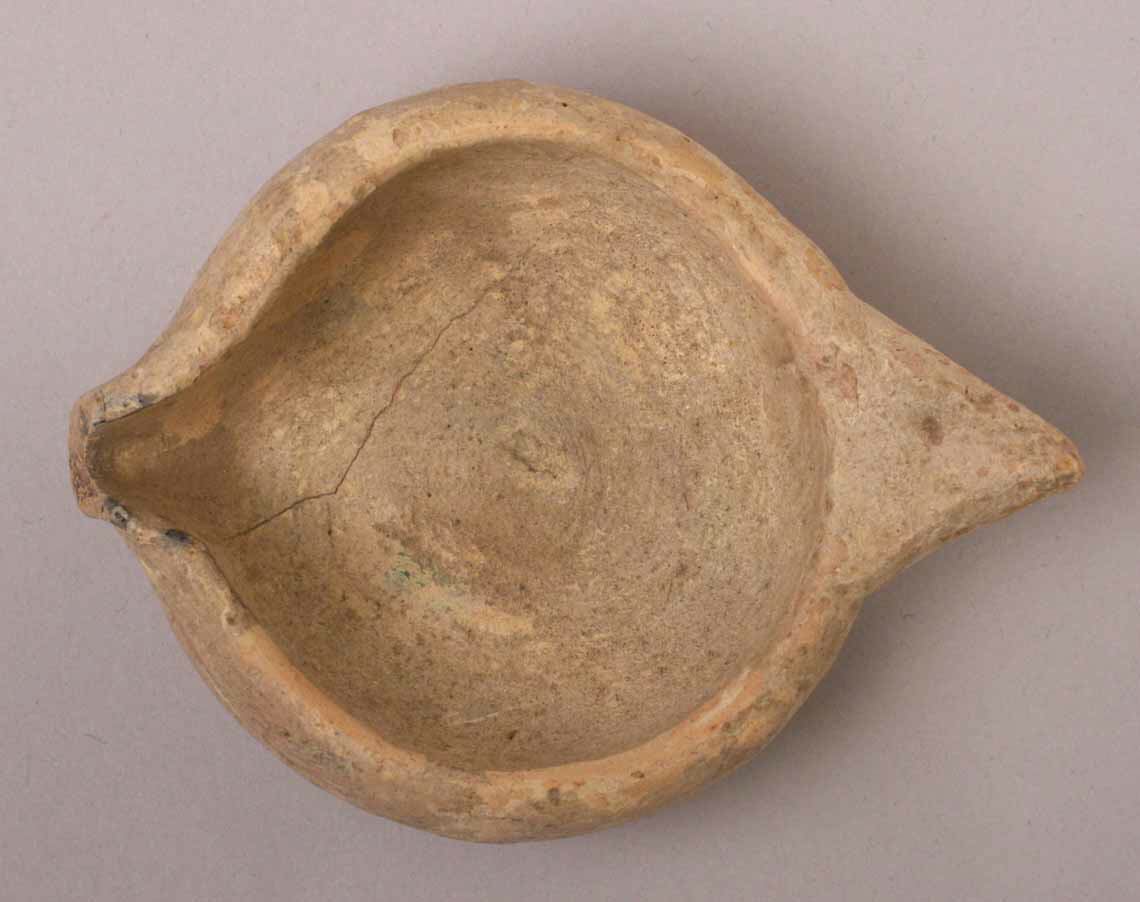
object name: lamp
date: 801-1100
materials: earthenware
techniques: glazing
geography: iran